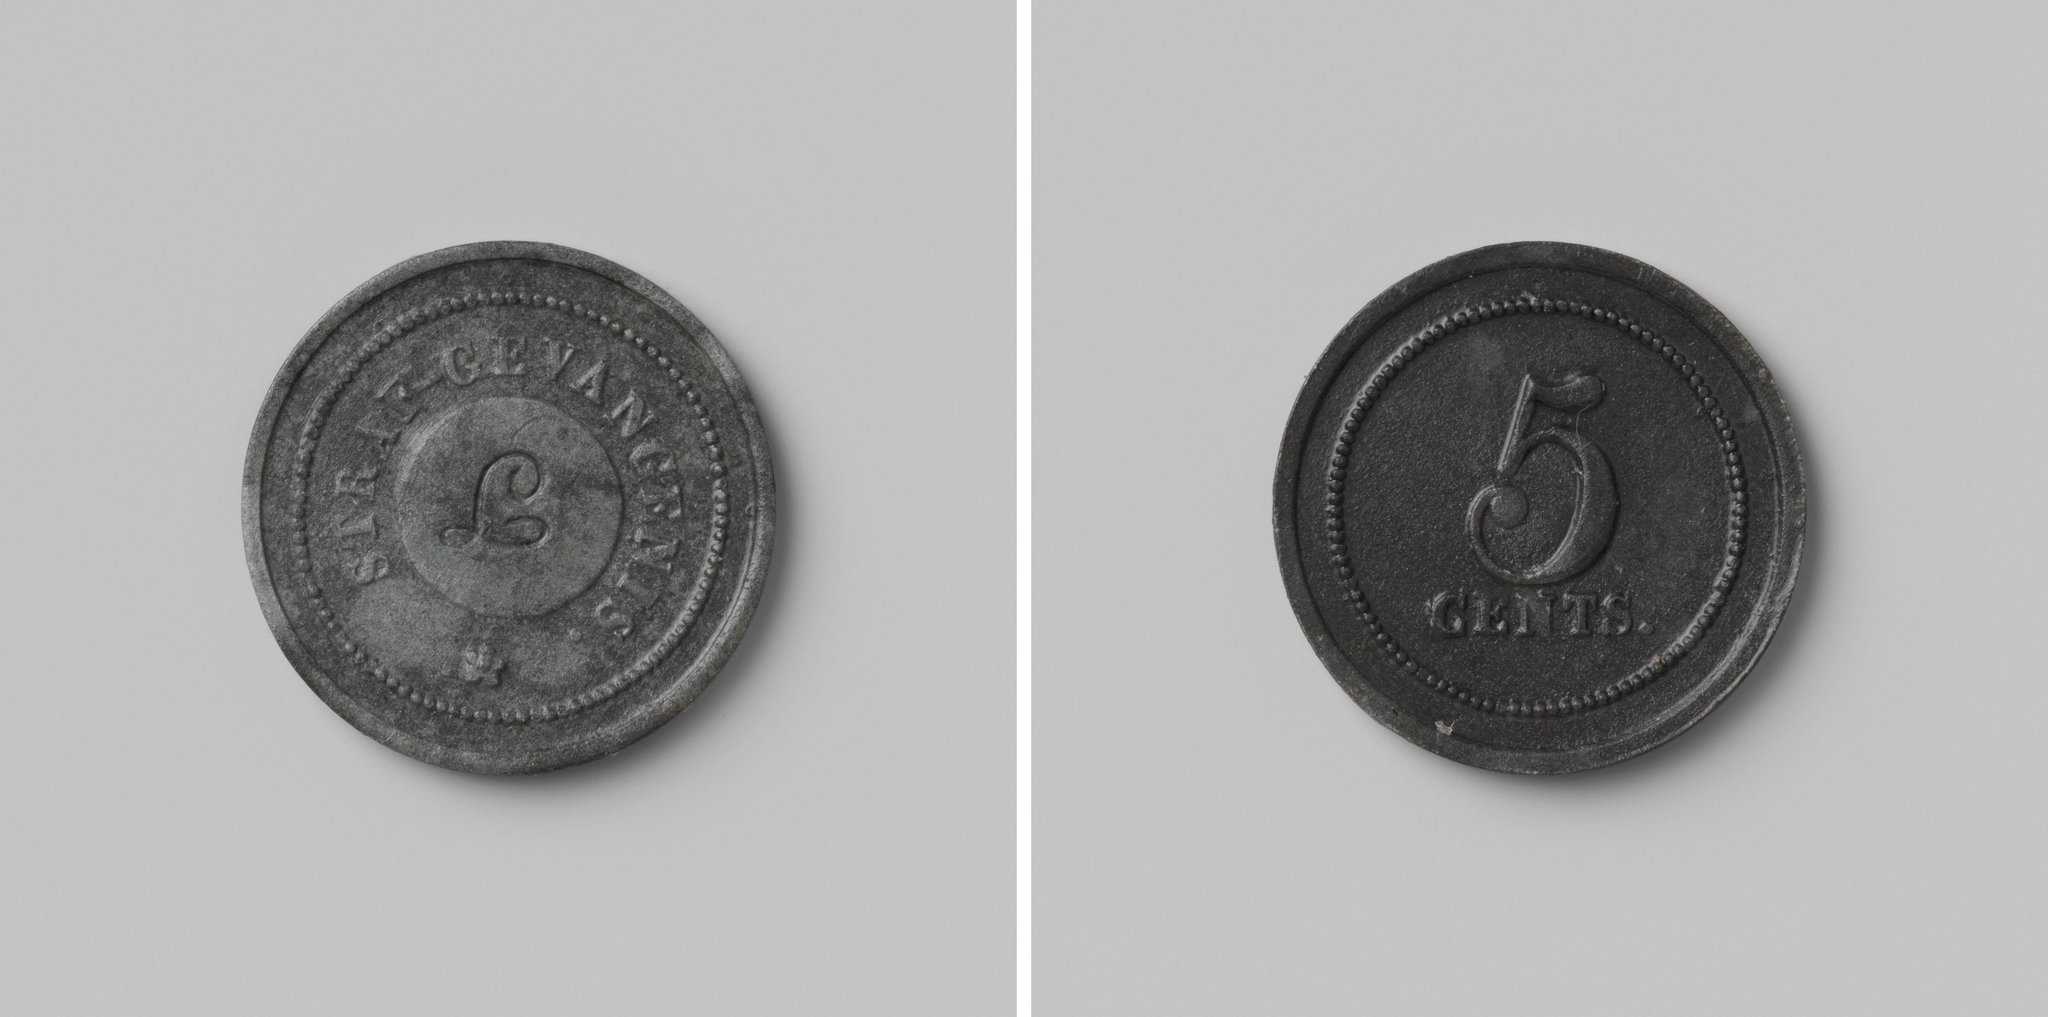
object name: vijf cent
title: Strafgevangenis te Leeuwarden, huismunt ter waarde van vijf cents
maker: Anonymous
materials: zinc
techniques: striking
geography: utrecht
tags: leeuwarden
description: Zinken betaalpenning. Voorzijde: letter L binnen omschrift. Keerzijde: waardeaanduiding